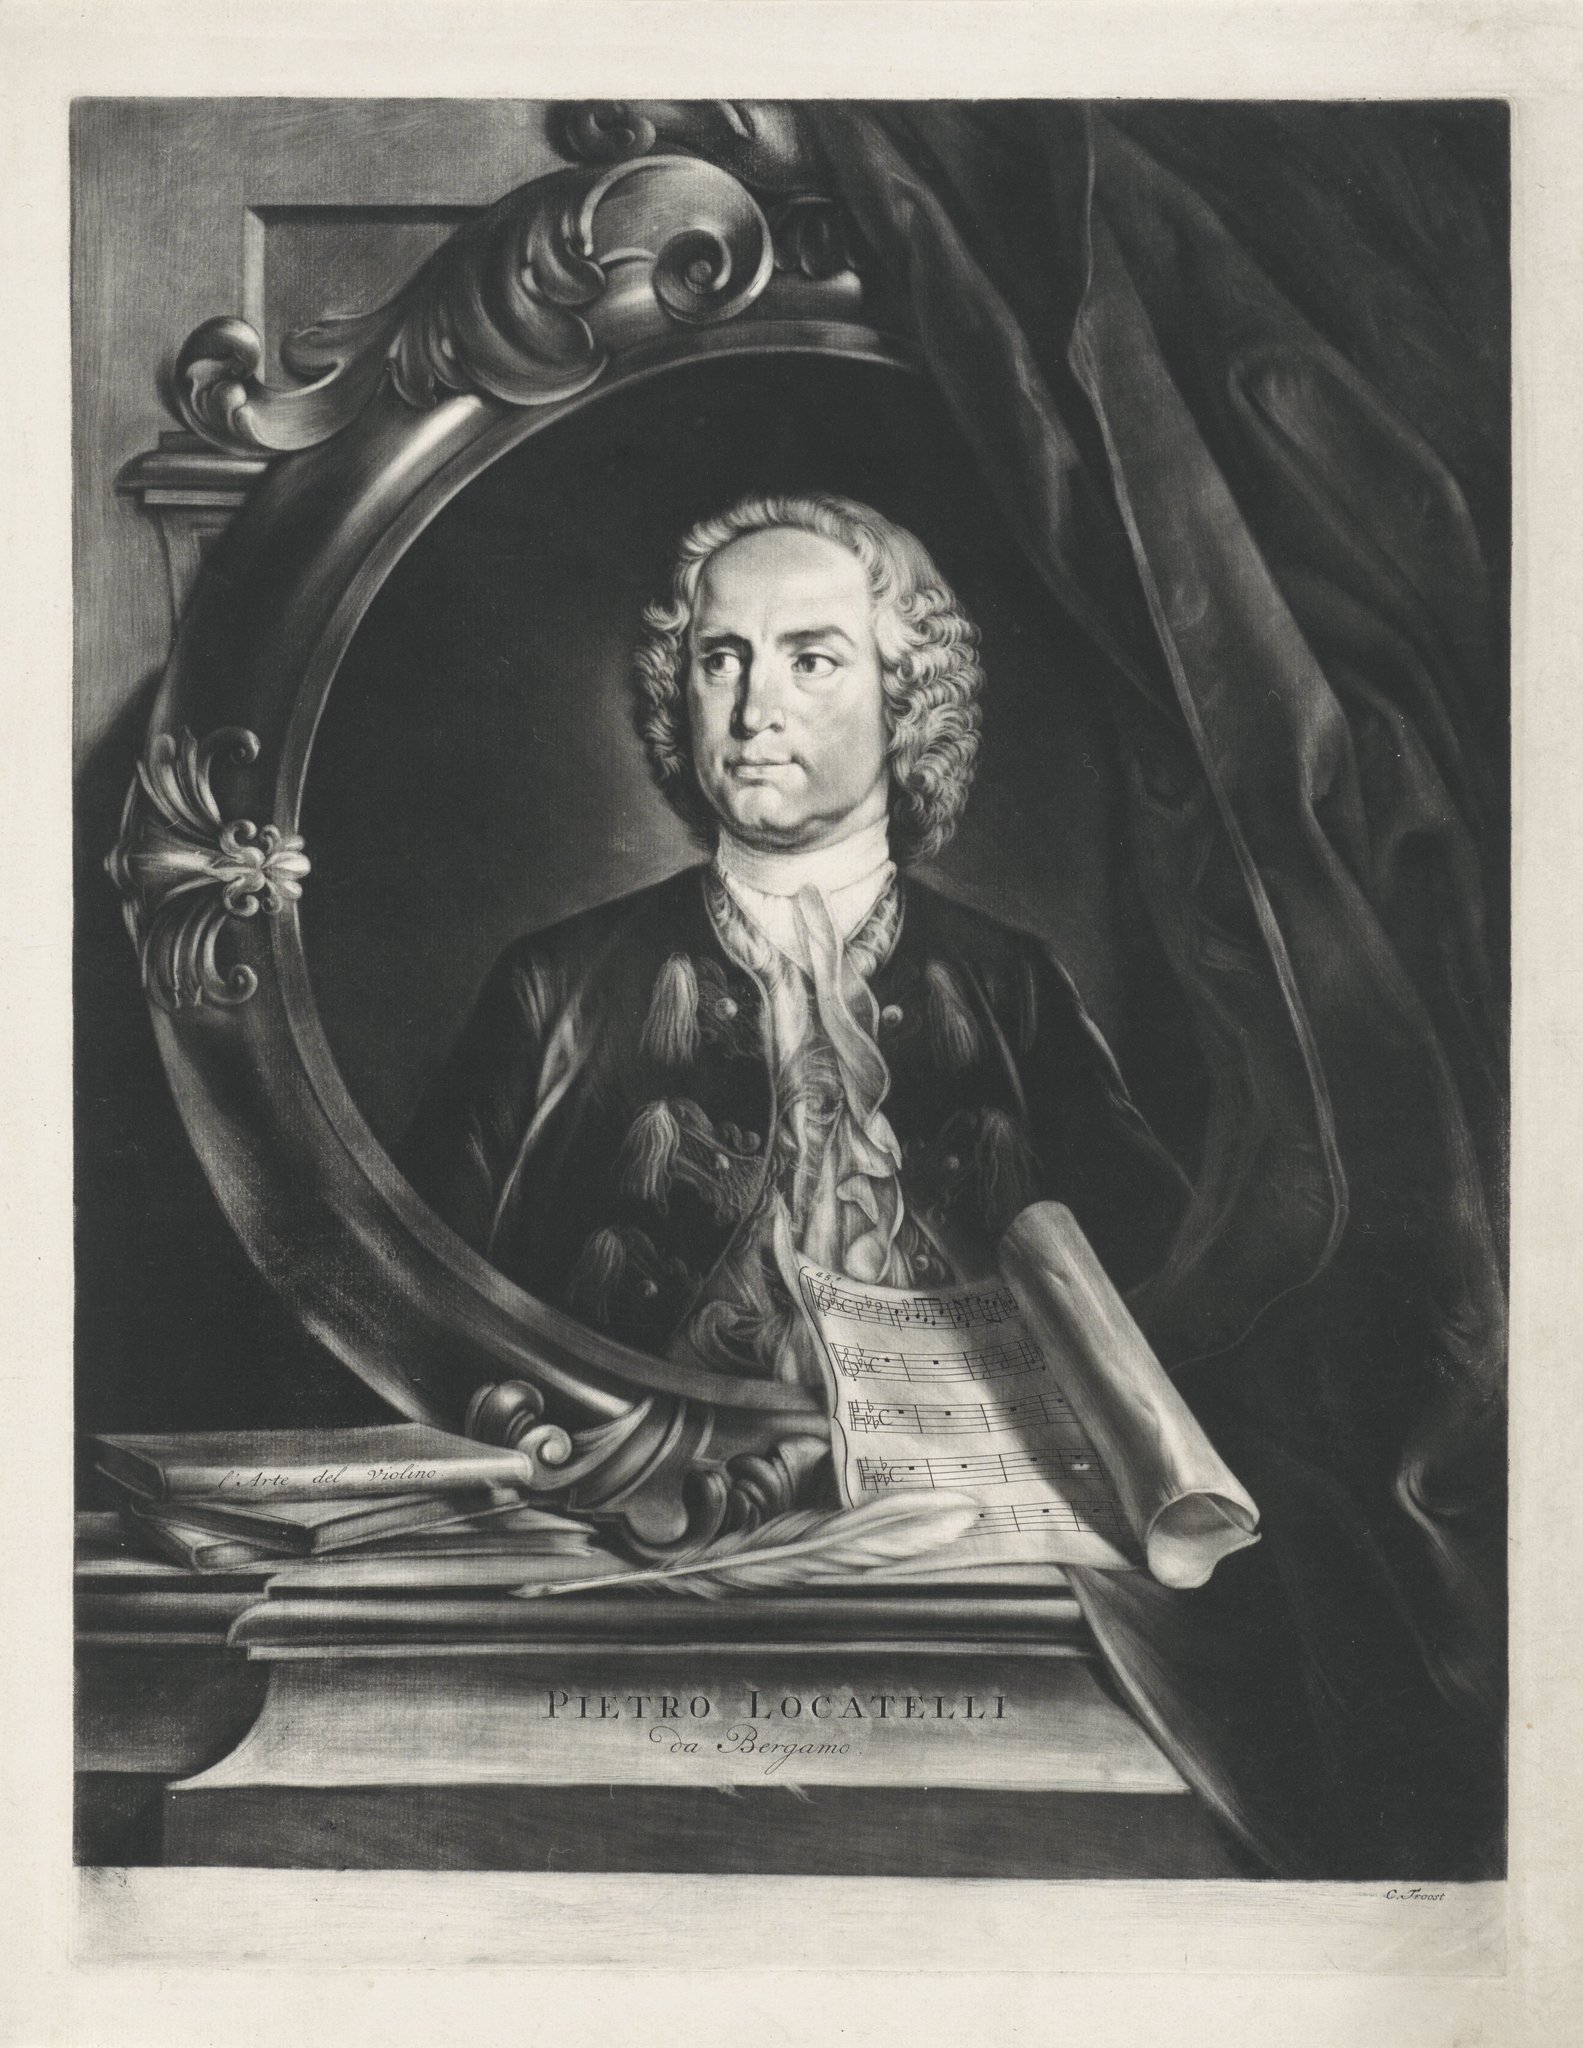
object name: print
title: Portret van Pietro Antonio Locatelli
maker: cornelis troost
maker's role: draughtsman, painter, print maker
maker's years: 1696-1750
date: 1729-1750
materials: paper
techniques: engraving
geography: amsterdam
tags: quill, portrait of composer, printed edition of musical score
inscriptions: collector's mark: Lugt 240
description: De Italiaanse componist en vioolleraar Pietro Antonio Locatelli. Voor de omlijsting een stapel boeken, een schrijfveer en een vel bladmuziek.